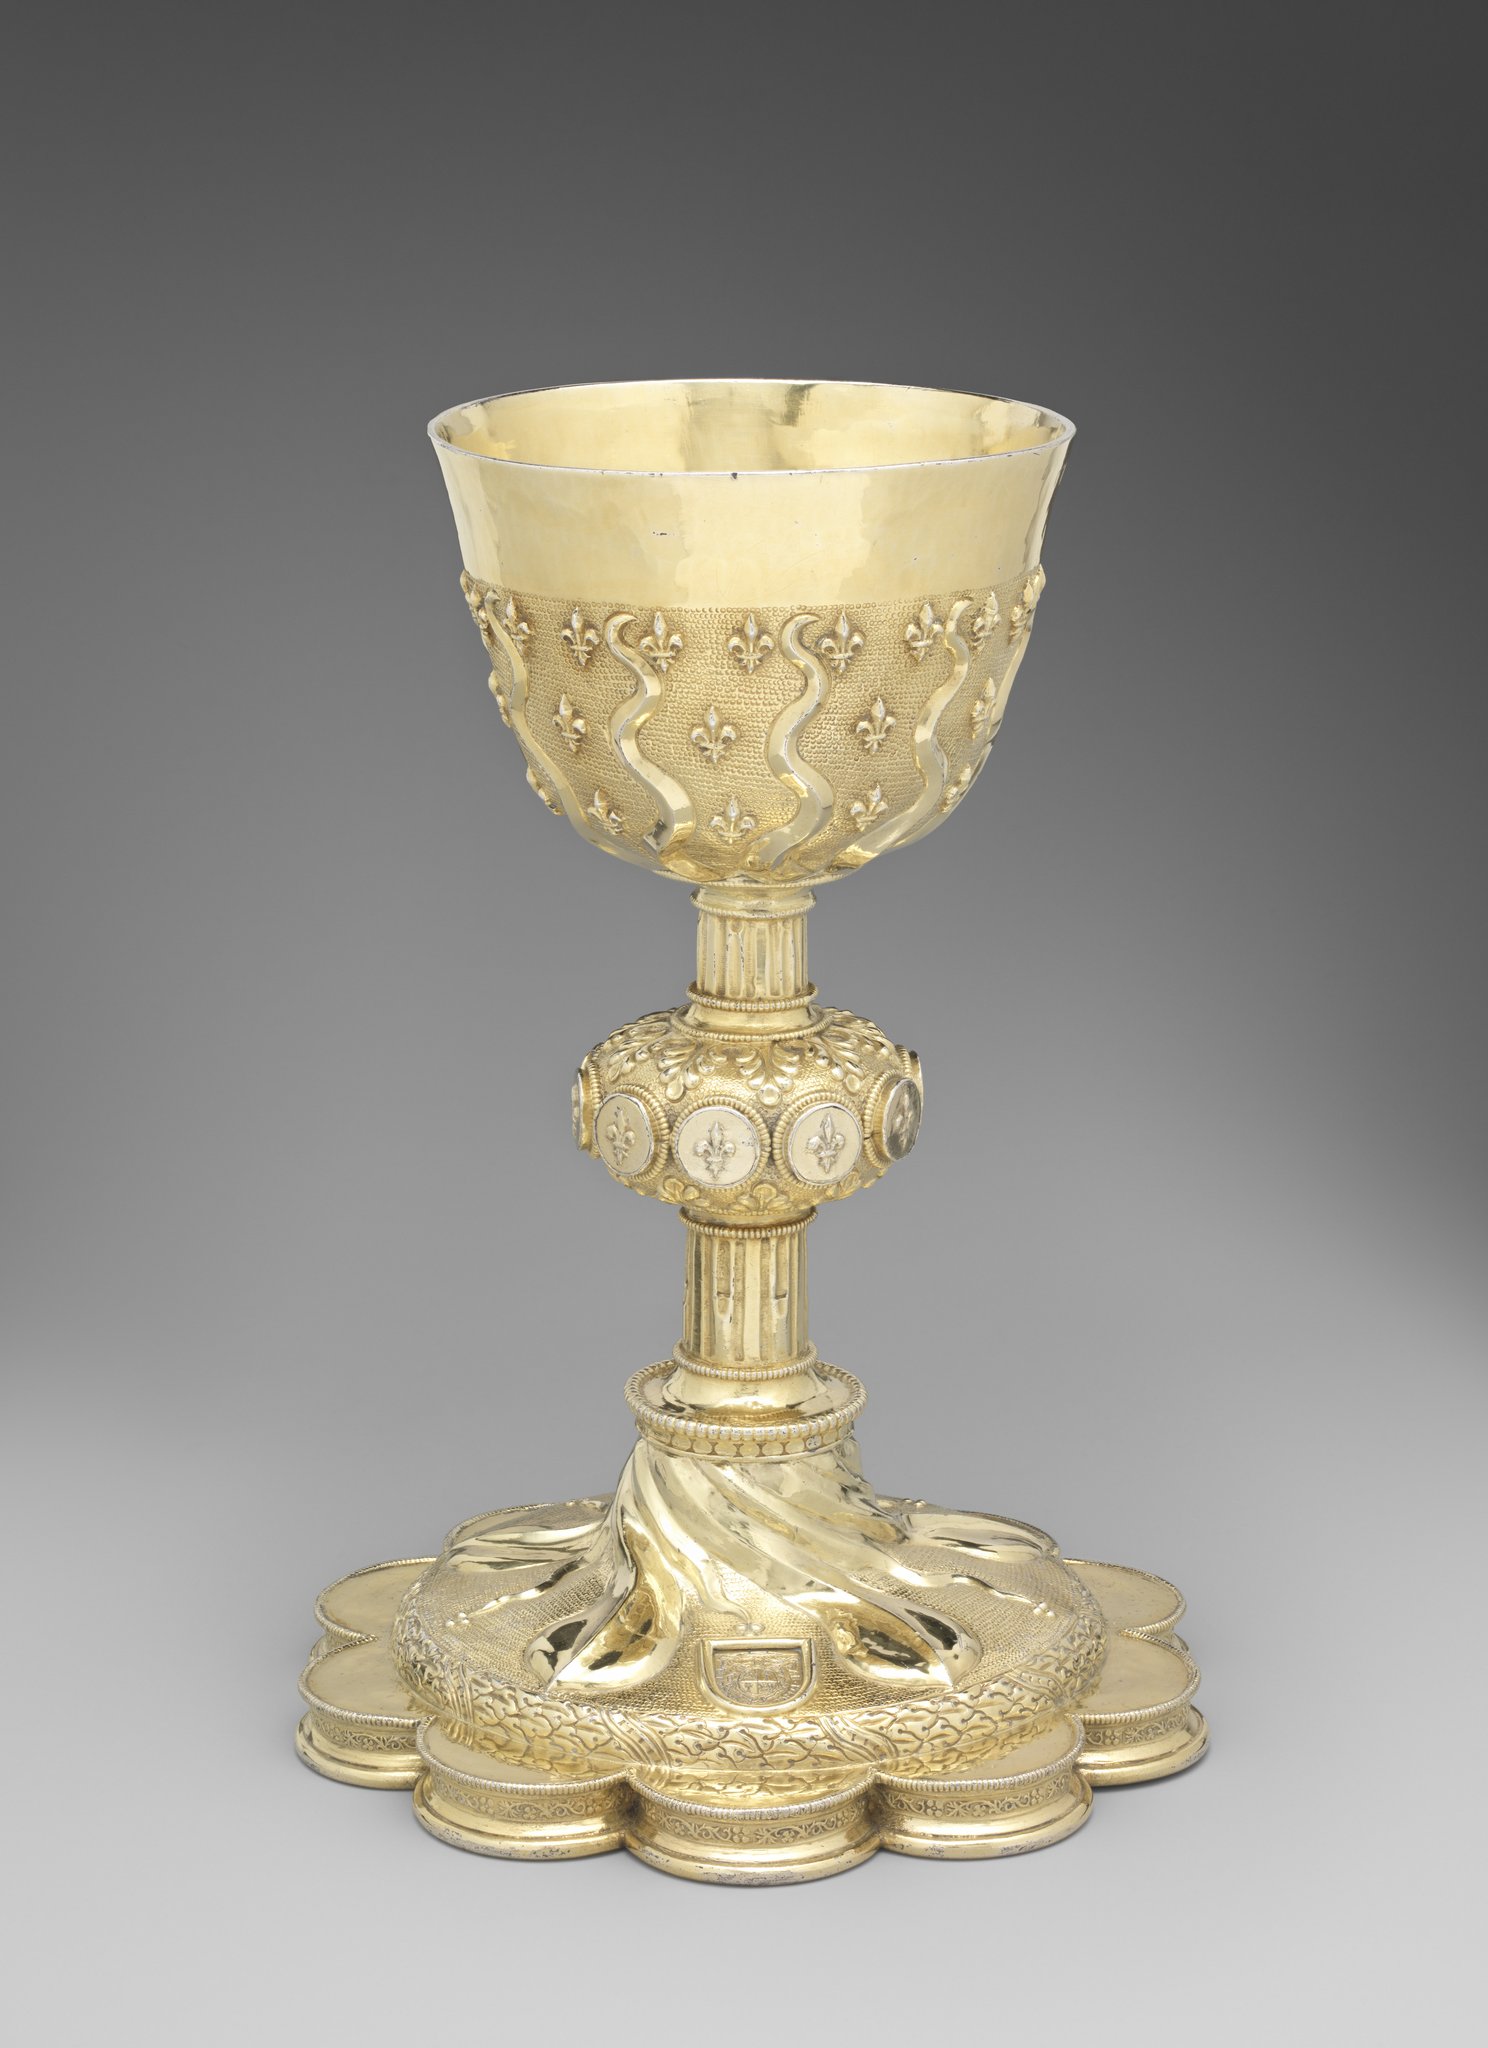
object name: chalice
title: Chalice à soleil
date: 1532-1533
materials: gilt silver